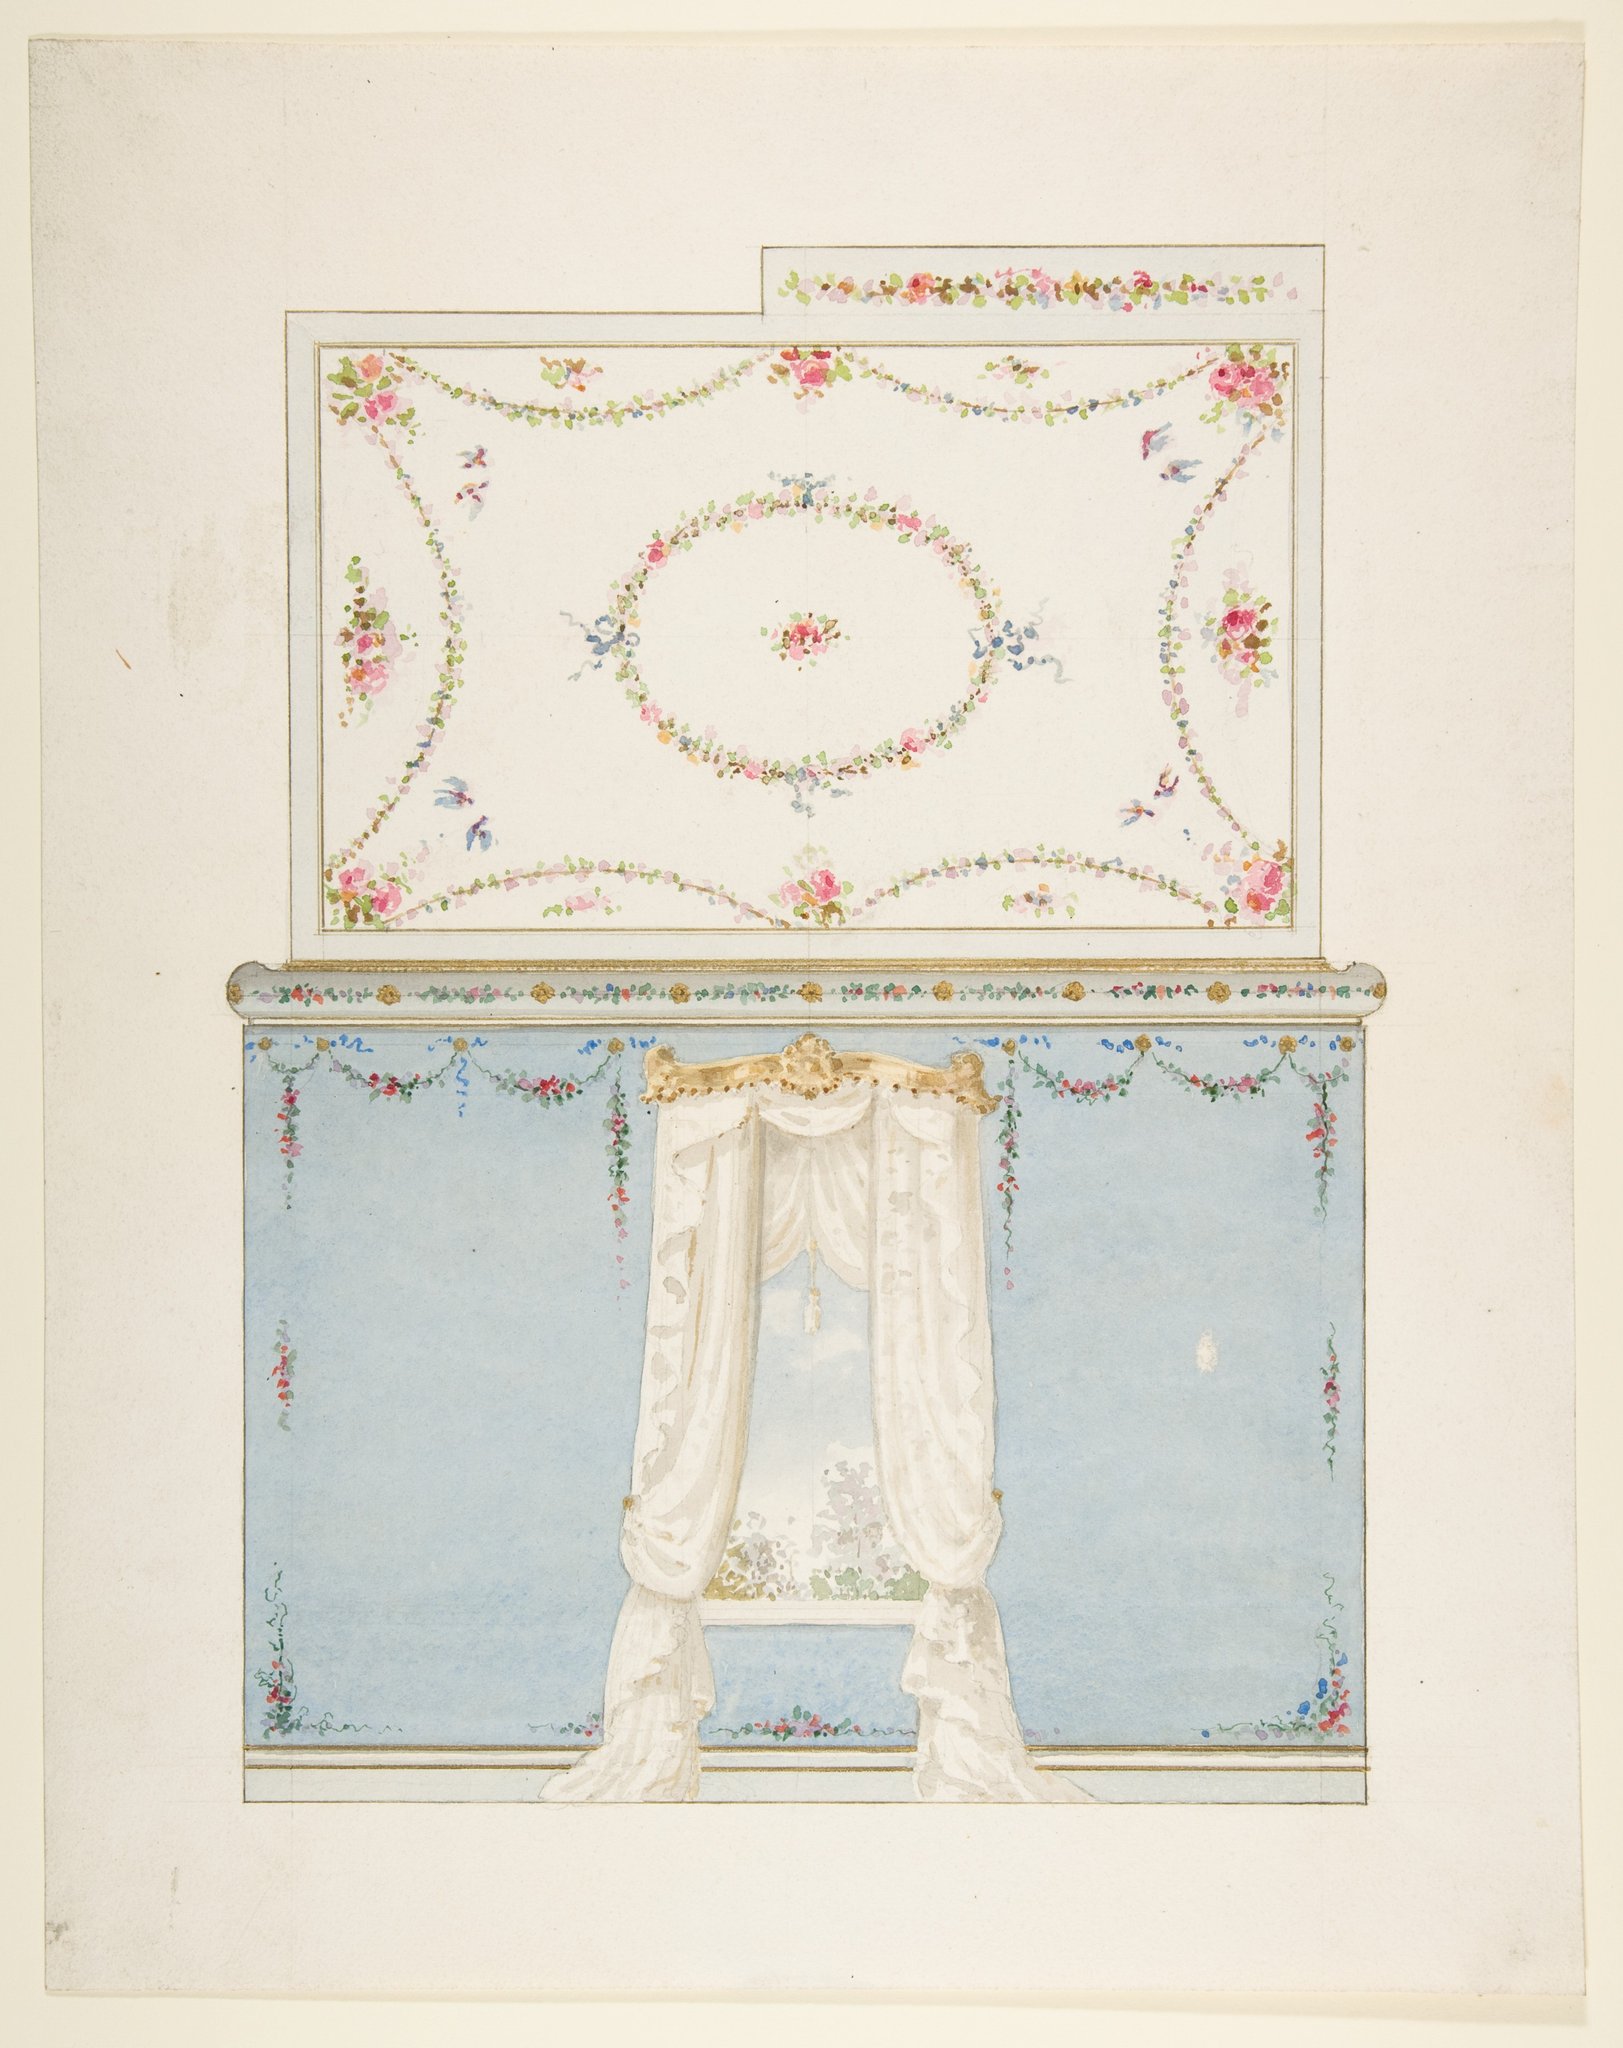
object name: drawing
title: Ceiling and wall design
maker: anonymous, french, 19th century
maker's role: artist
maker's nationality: french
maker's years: 1800-1900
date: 1801-1900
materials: ink, watercolor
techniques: pen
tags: architecture,flowers